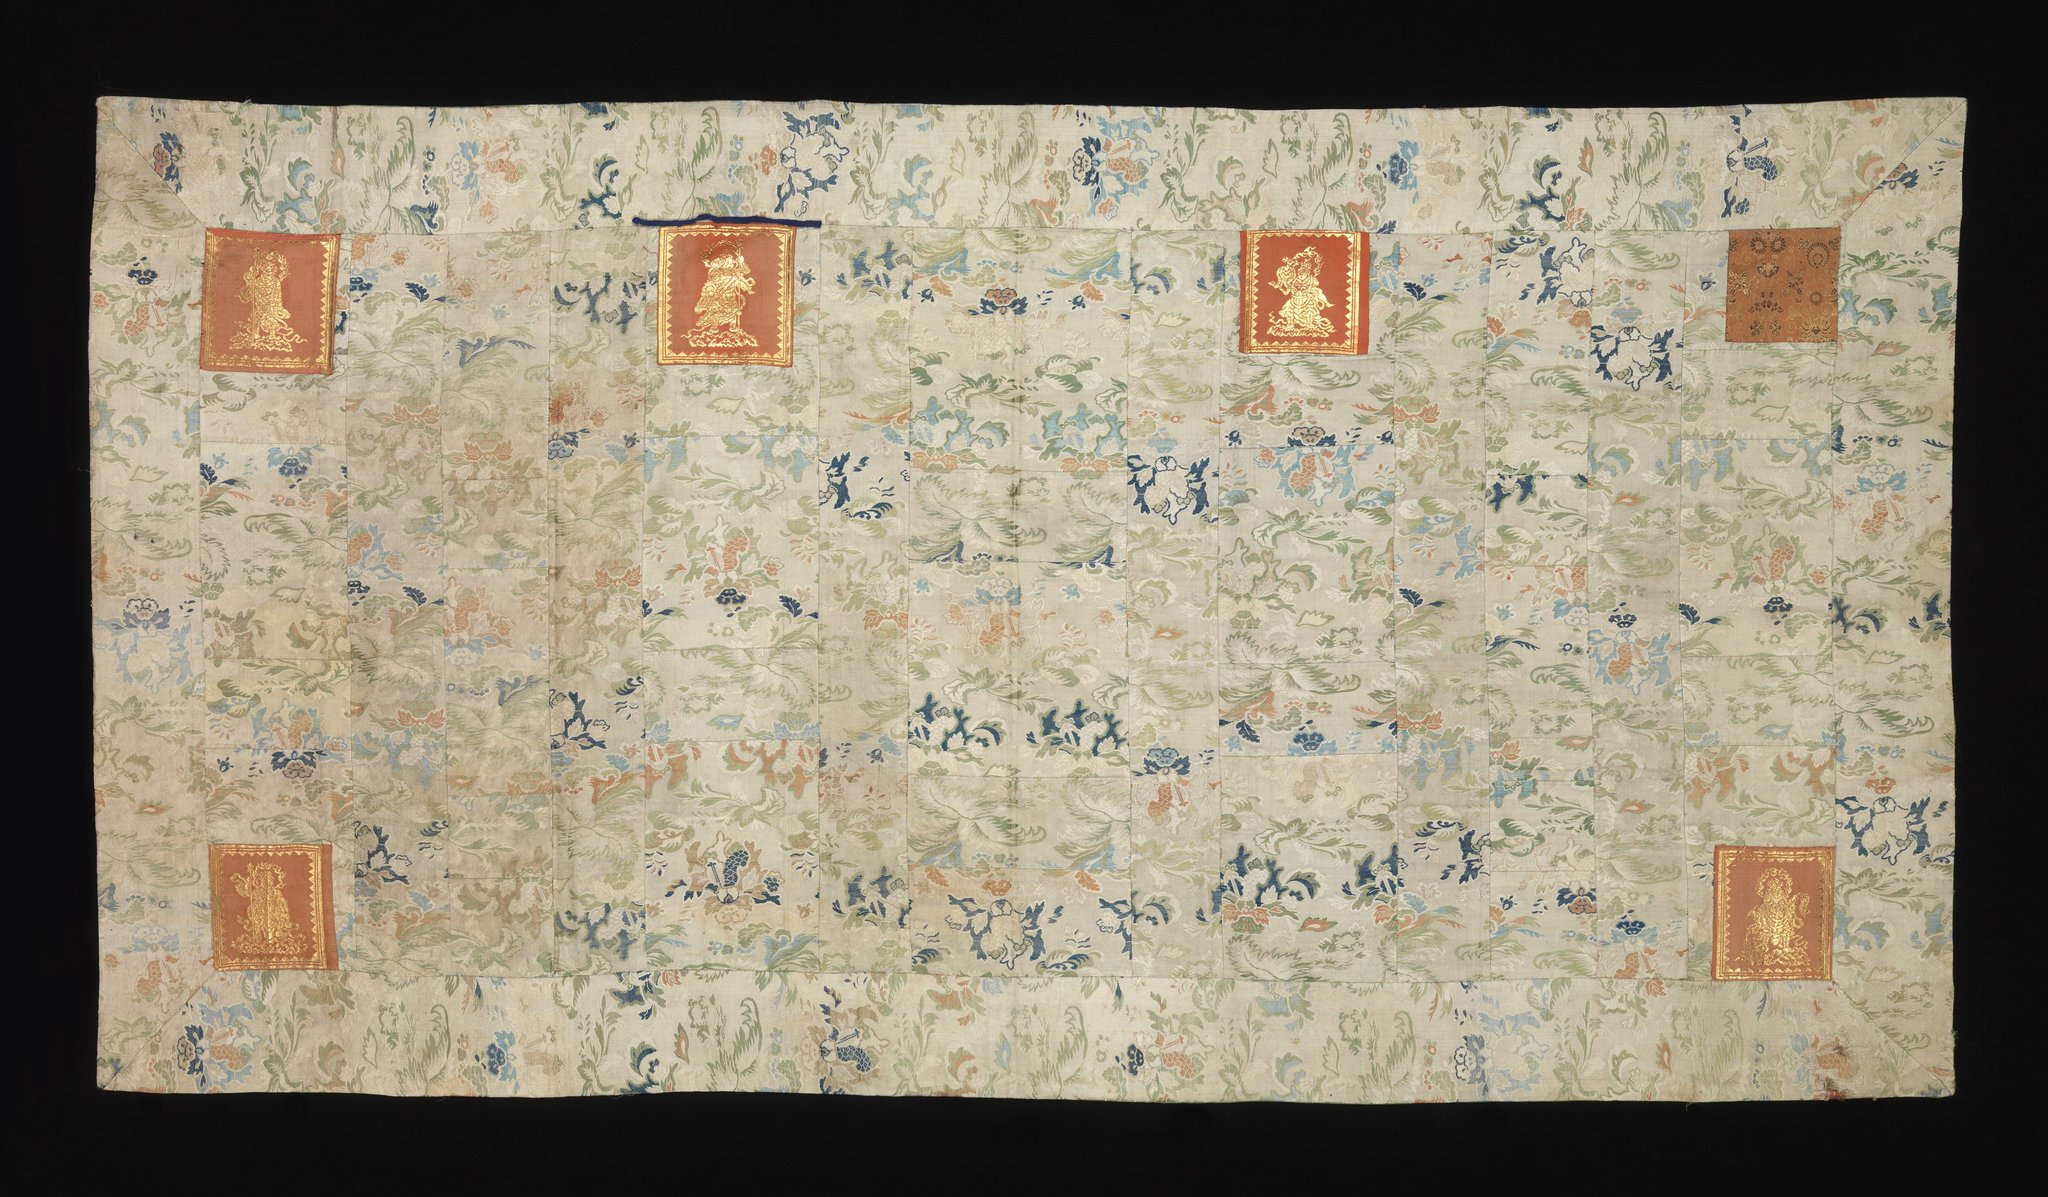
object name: robe, priest's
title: Buddhist Vestment (Kesa) with Figural Squares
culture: japanese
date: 1701-1800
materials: metal thread, silk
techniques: lampas, patterning, weave